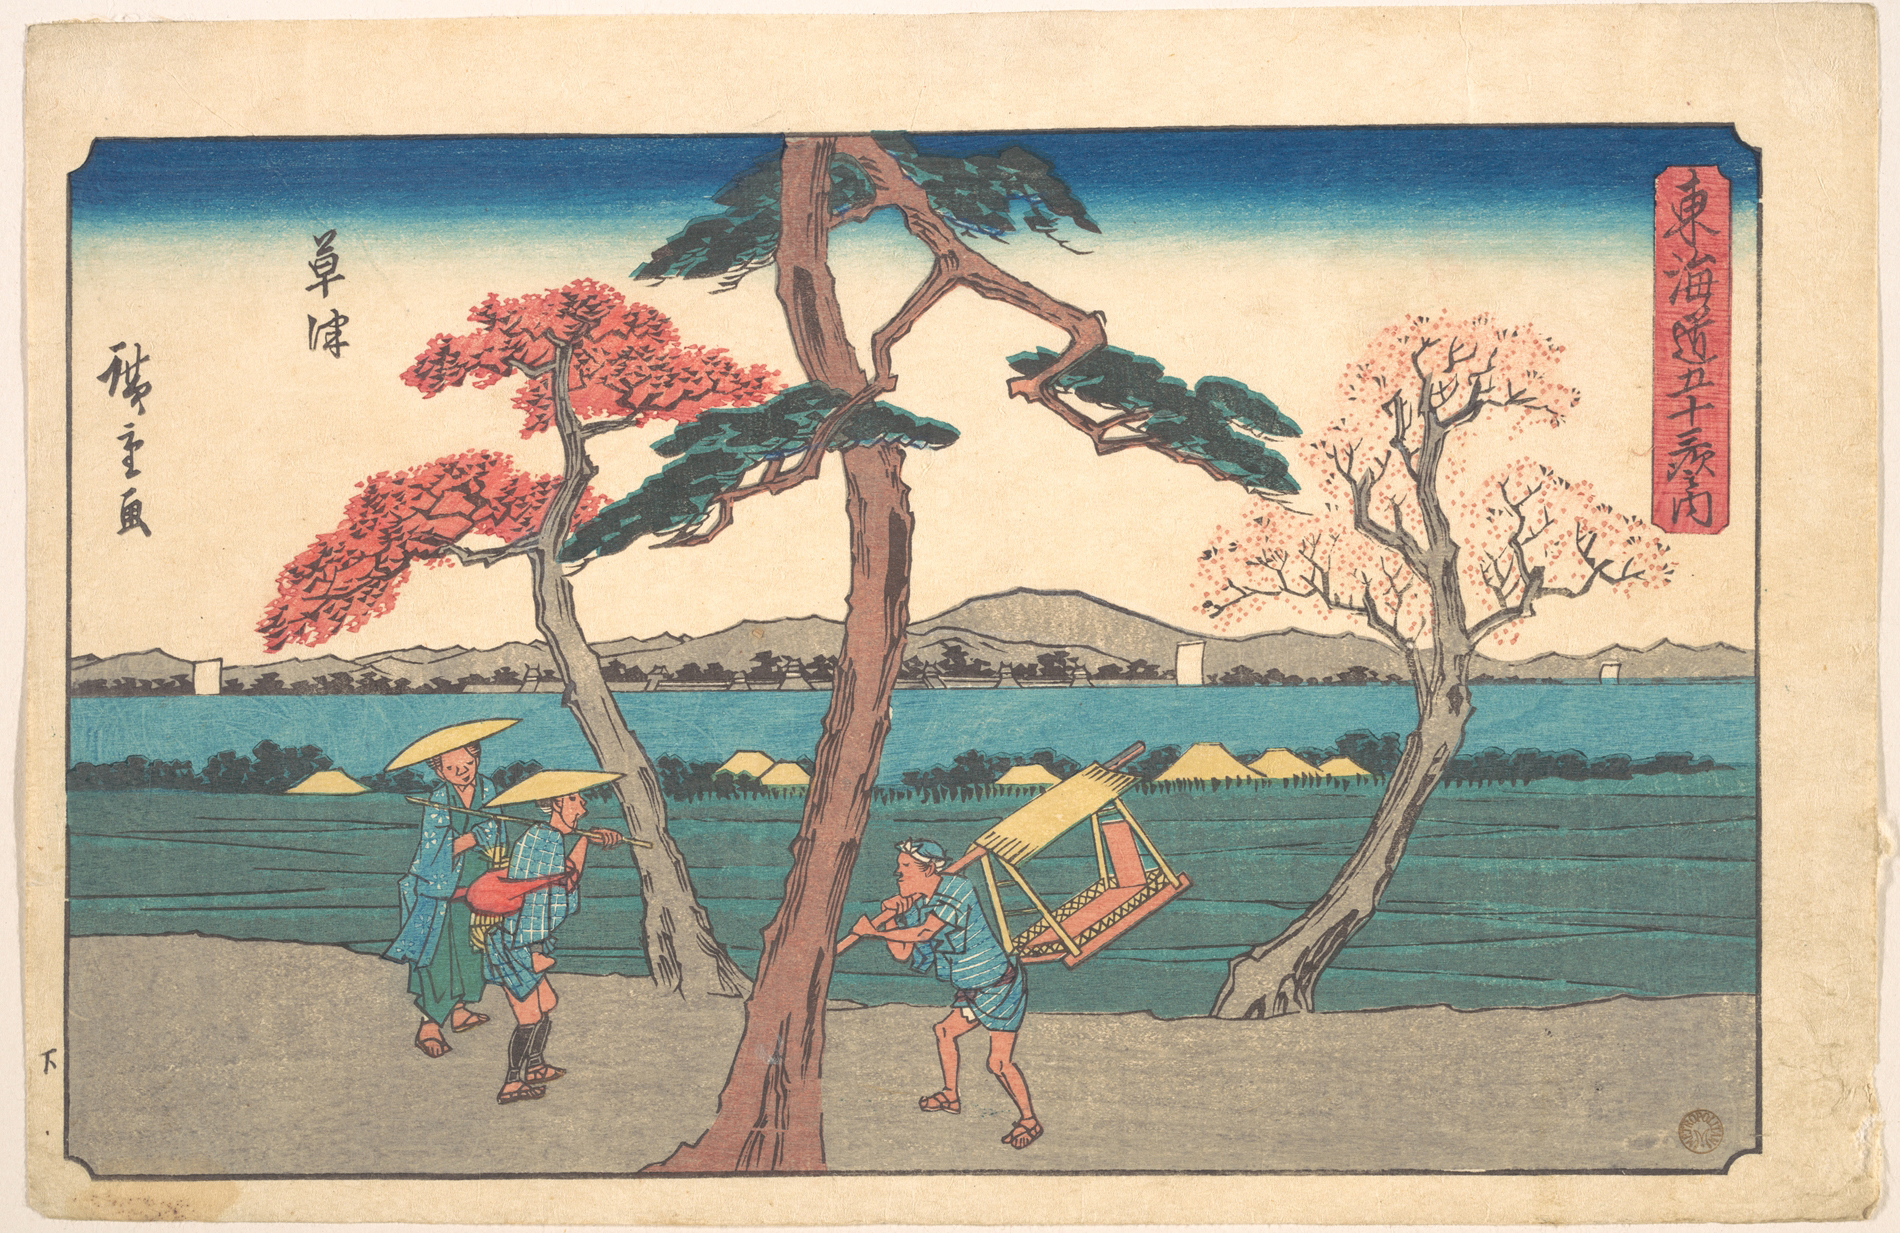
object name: print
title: Kusatsu Station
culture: japanese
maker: utagawa hiroshige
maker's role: artist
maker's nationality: japanese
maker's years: 1797-1858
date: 1842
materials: ink, paper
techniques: woodblock print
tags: men,mountains,trees